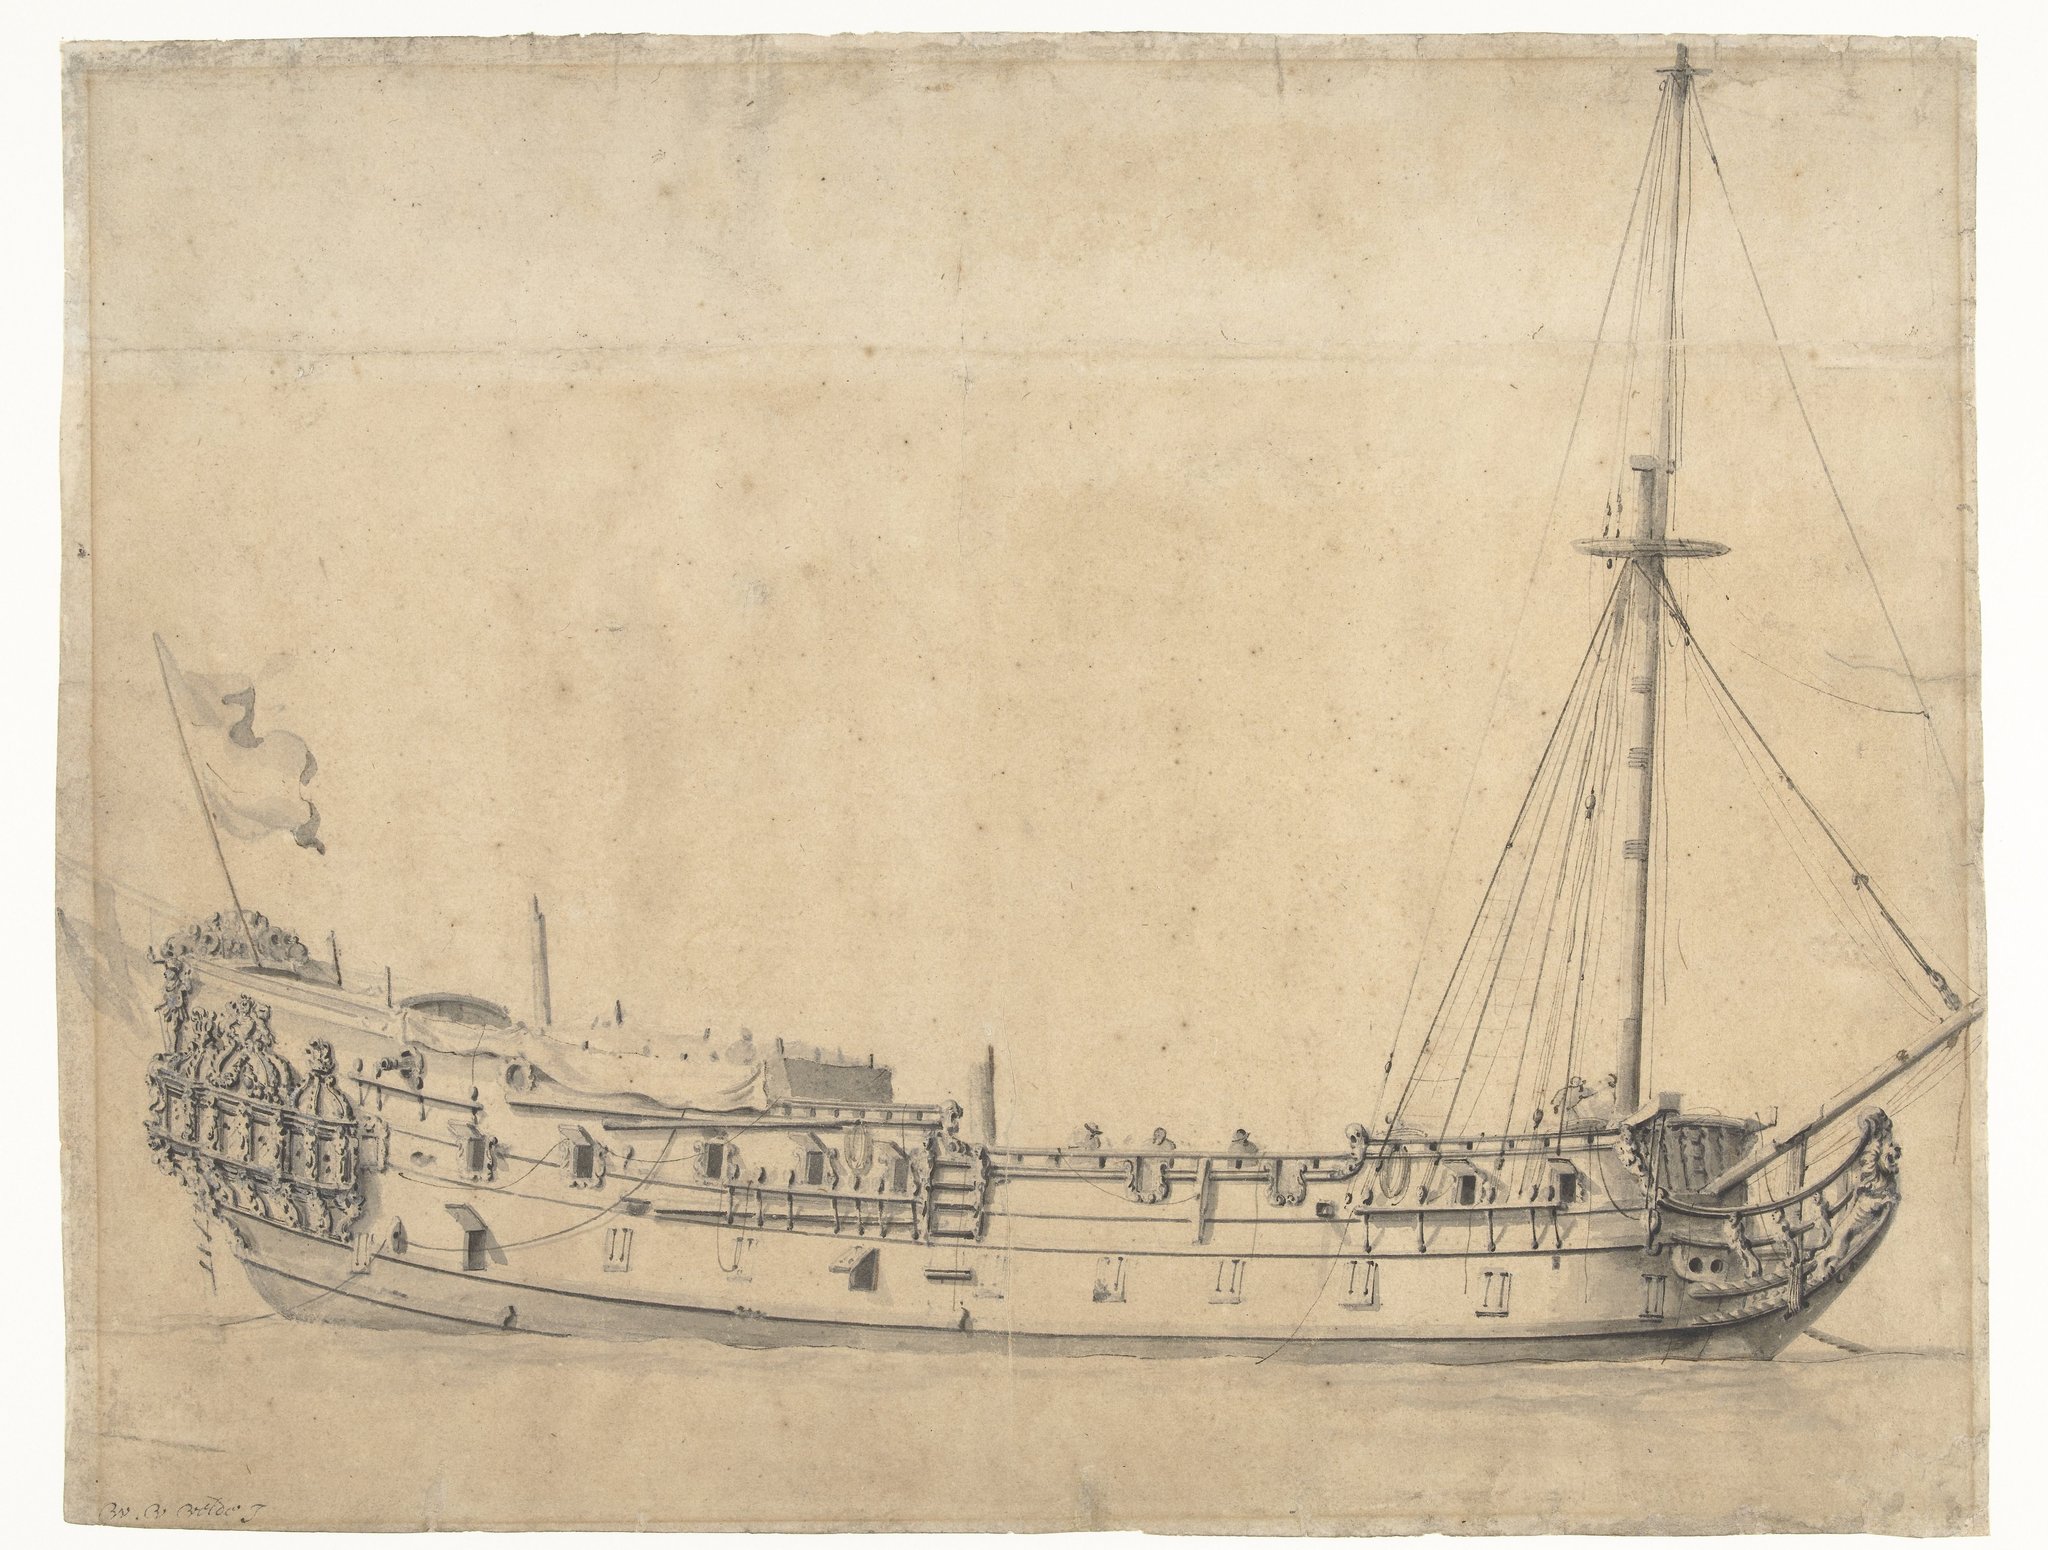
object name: drawing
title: De Loyal George, opgebracht na de Vierdaagse Zeeslag in Juni 1666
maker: willem van de velde (ii)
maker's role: draughtsman, painter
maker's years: 1633-1707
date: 1666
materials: paint, paper, pencil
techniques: brush, pen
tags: sailing-ship, sailing-boat, names of artefacts and man-made objects (buildings excluded), navy (+ sailing-ships)